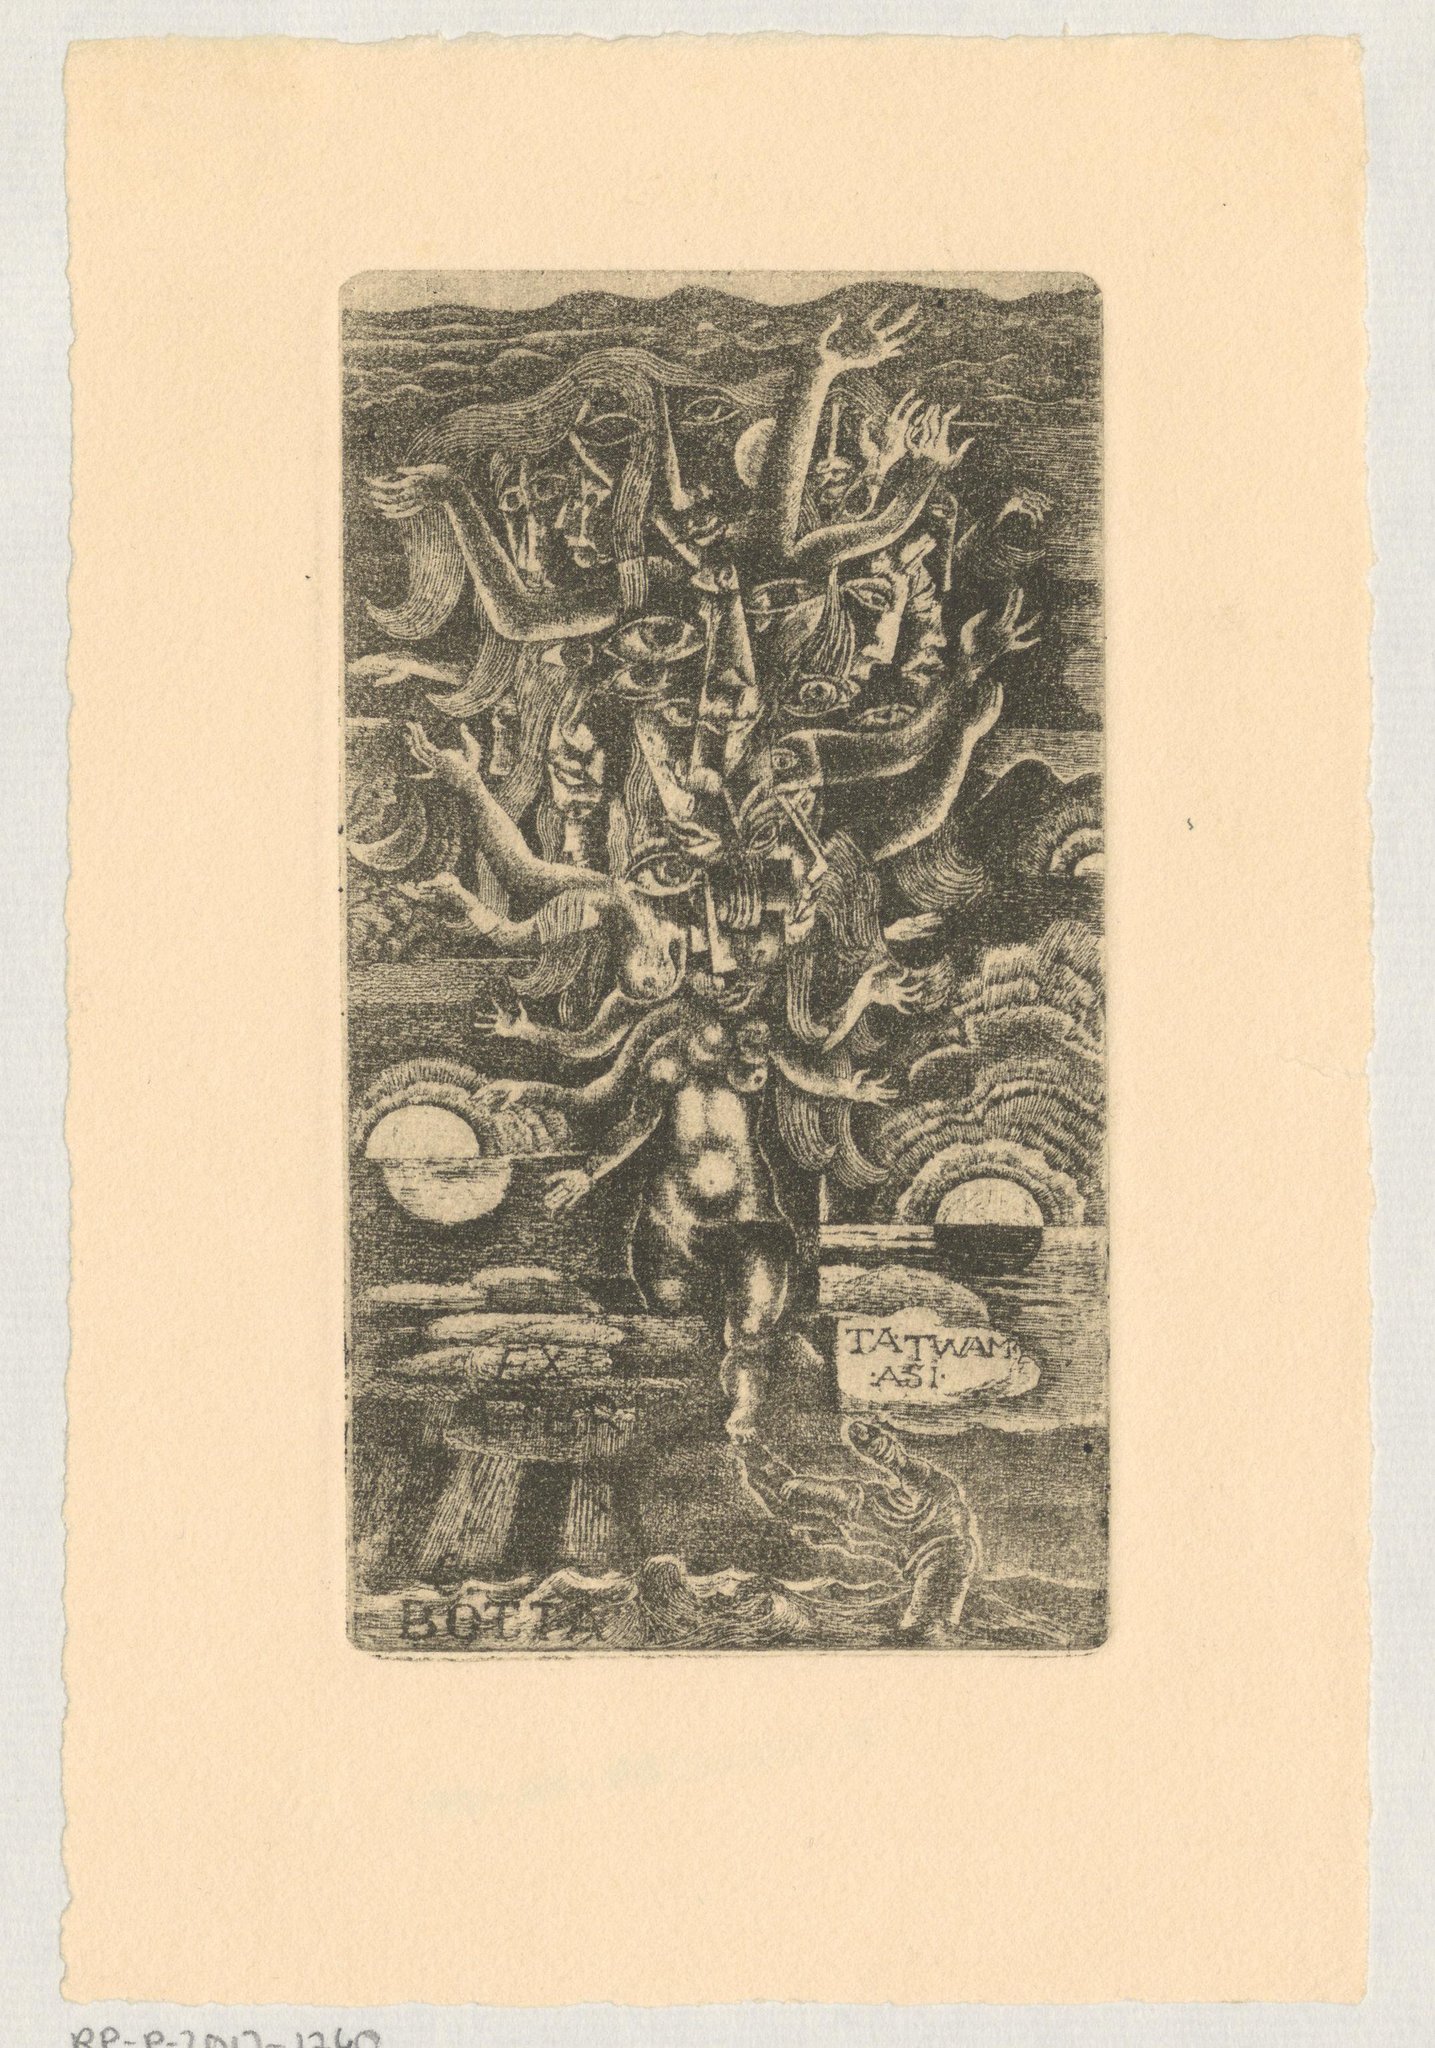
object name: bookplate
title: Ex libris van G. Botta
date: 1916-1943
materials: paper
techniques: rotogravure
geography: italy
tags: politician, arm raised upward, woman (showing herself) undressed, quasi-nude, disabilities, deformations, eyes, sunrise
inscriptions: number: ‘58’, workshop stamp: ‘M. Fingesten-es-1584 (?)’